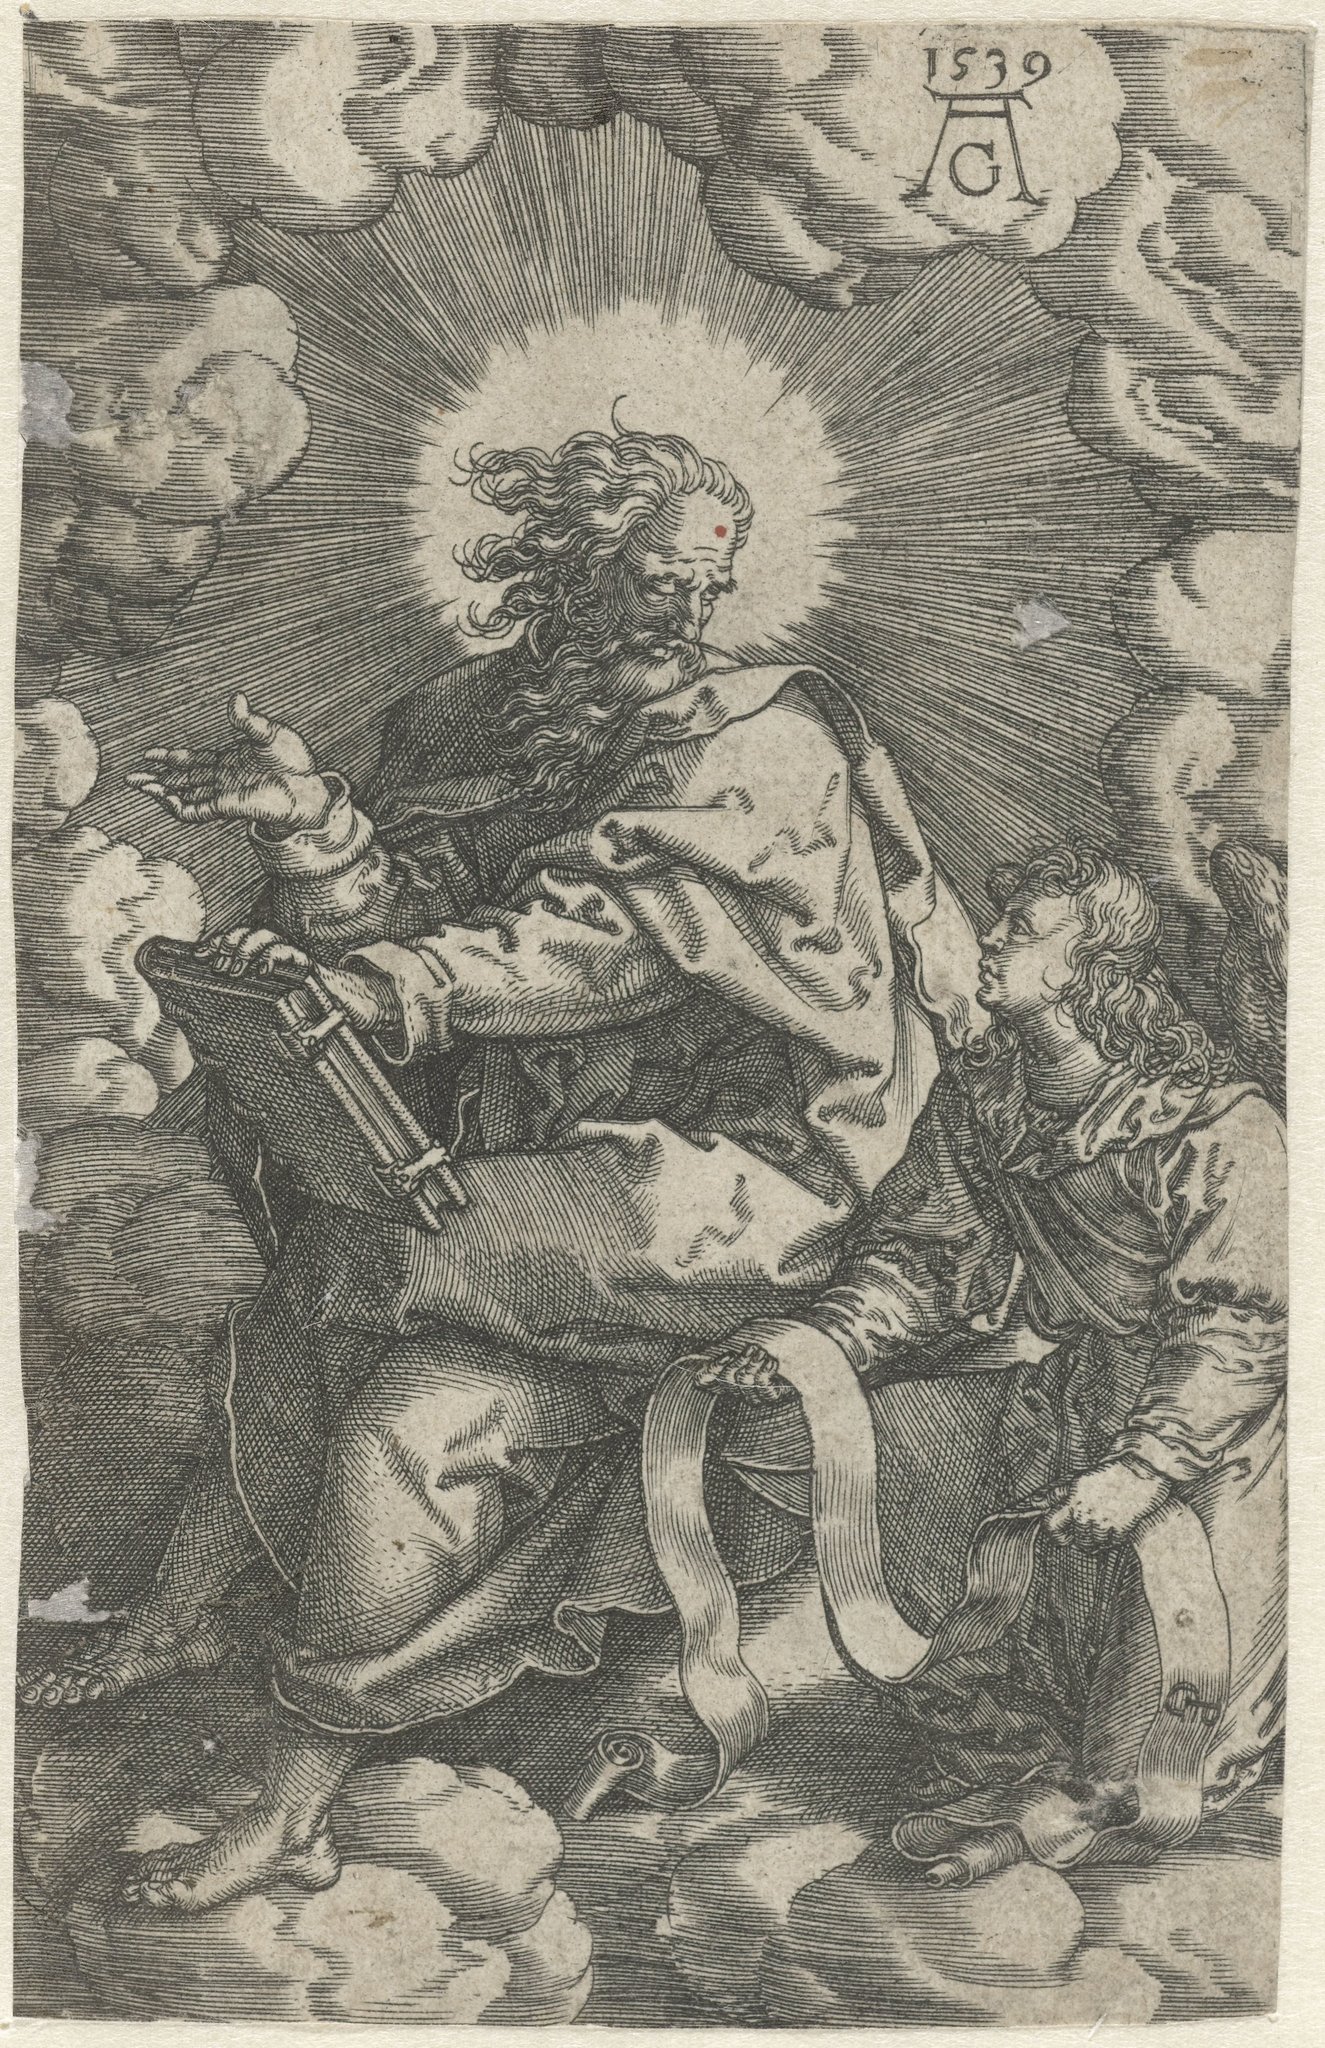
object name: print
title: Mattheüs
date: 1539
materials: paper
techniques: engraving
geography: germany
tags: the apostle and evangelist matthew (mattheus); possible attributes: angel, axe, book, halberd, pen and inkhorn, purse, scroll, square, sword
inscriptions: collector's mark: Lugt 2166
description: Mattheüs de evangelist zittend op een wolk, het evangelie in zijn linkerhand, links van hem de engel met een banderol in de handen.